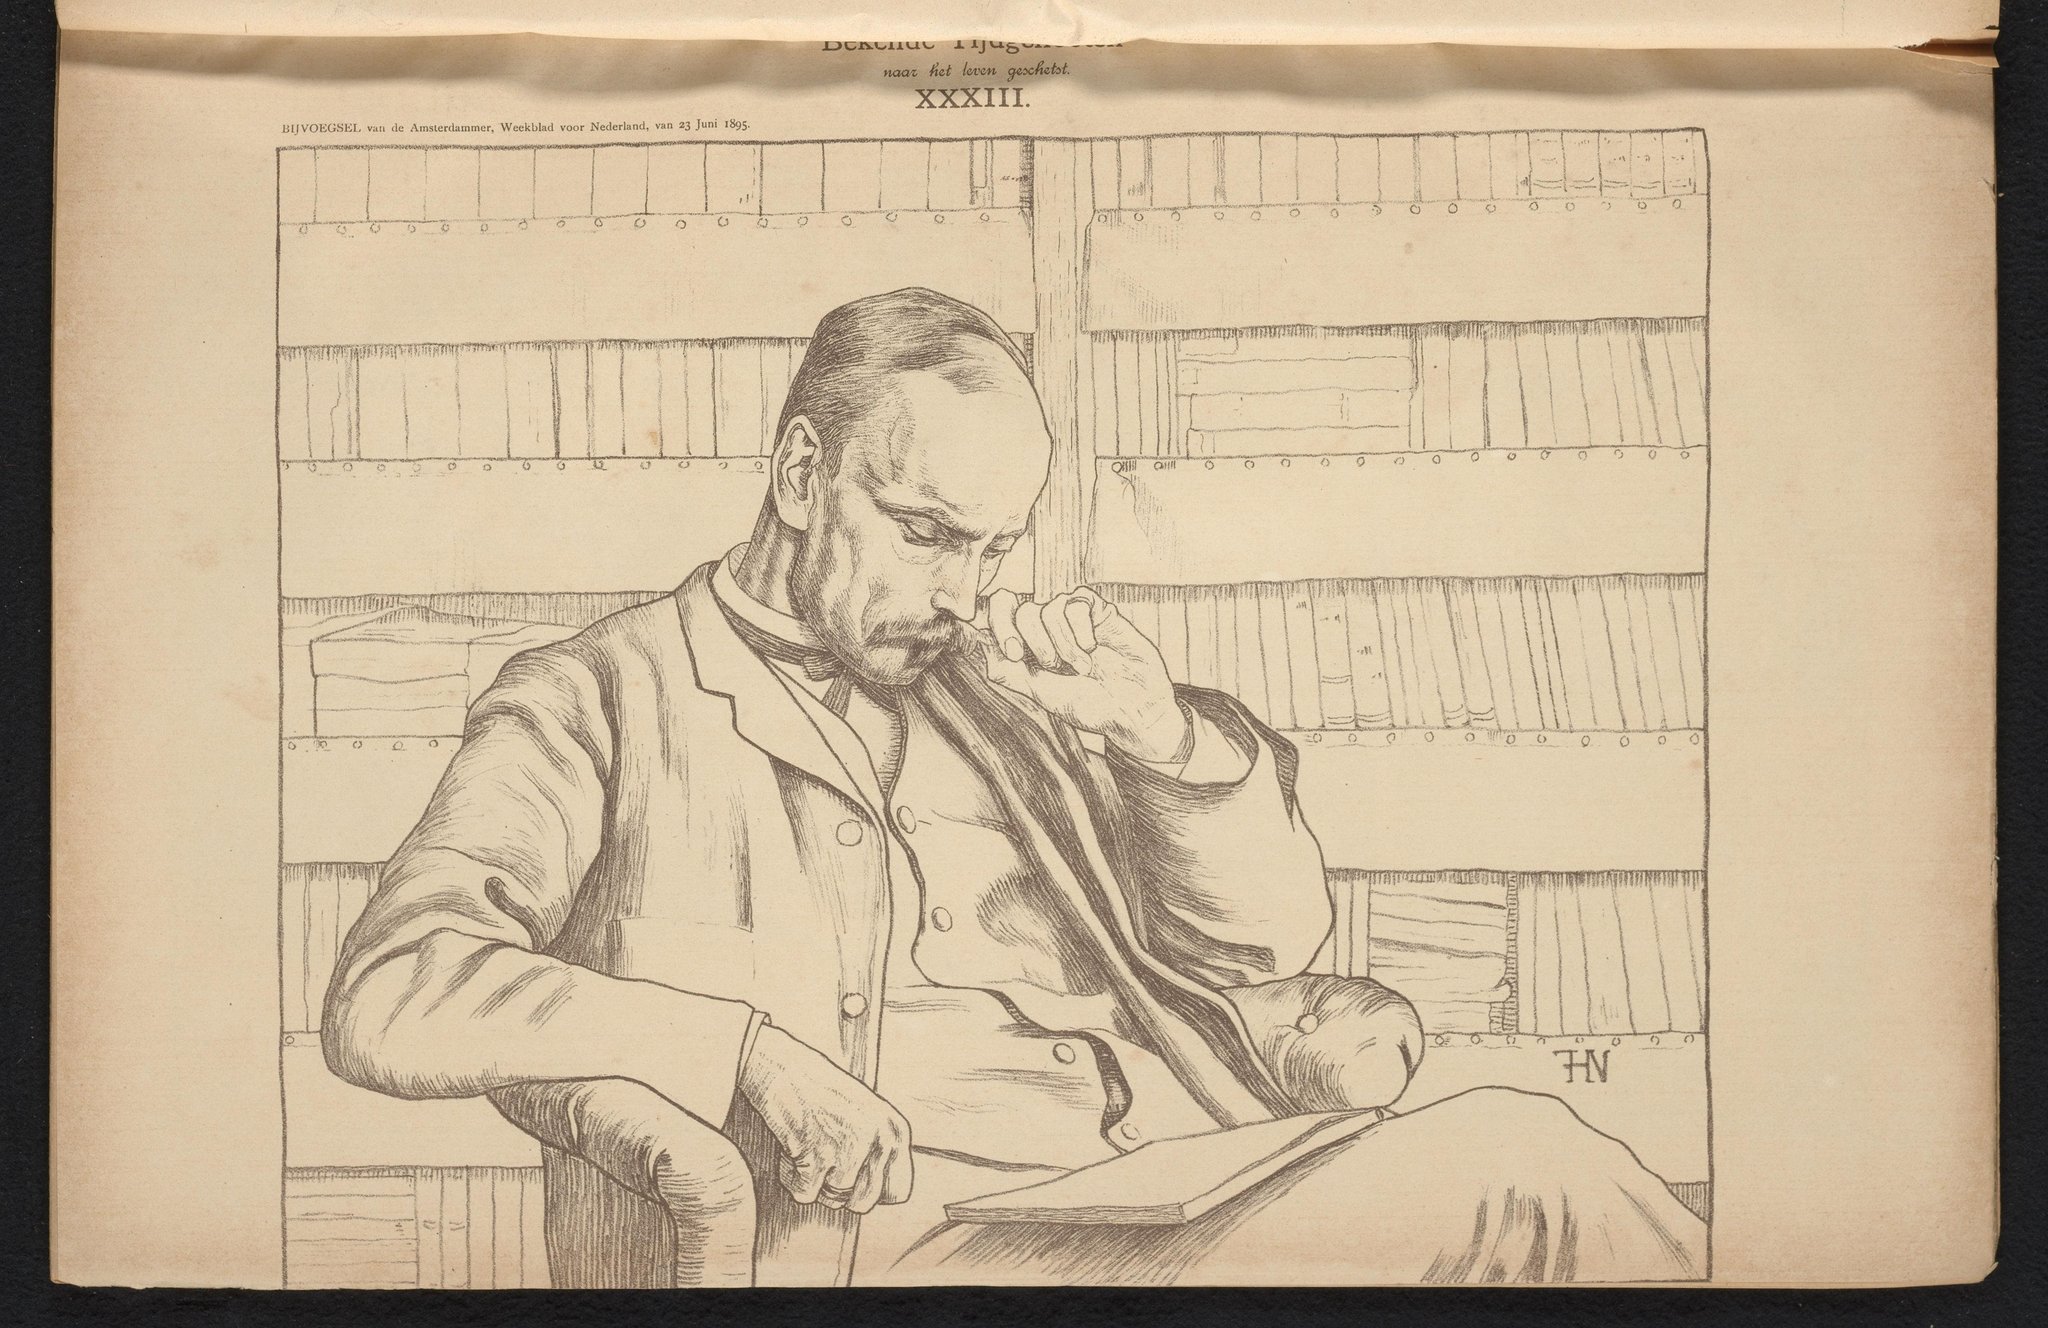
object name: print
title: Portret van Jacob Pieter Moltzer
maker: ferdinand hart nibbrig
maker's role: draughtsman, painter, print maker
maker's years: 1866-1915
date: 1895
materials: paper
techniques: lithograph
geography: amsterdam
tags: amsterdam, jacob pieter moltzer, reading, historical persons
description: Portret van de rechtsgeleerde Jacob Pieter Moltzer, lezend in een stoel voor een kast met boeken. In de serie 'Bekende Tijdgenooten', nr. XXXIII.